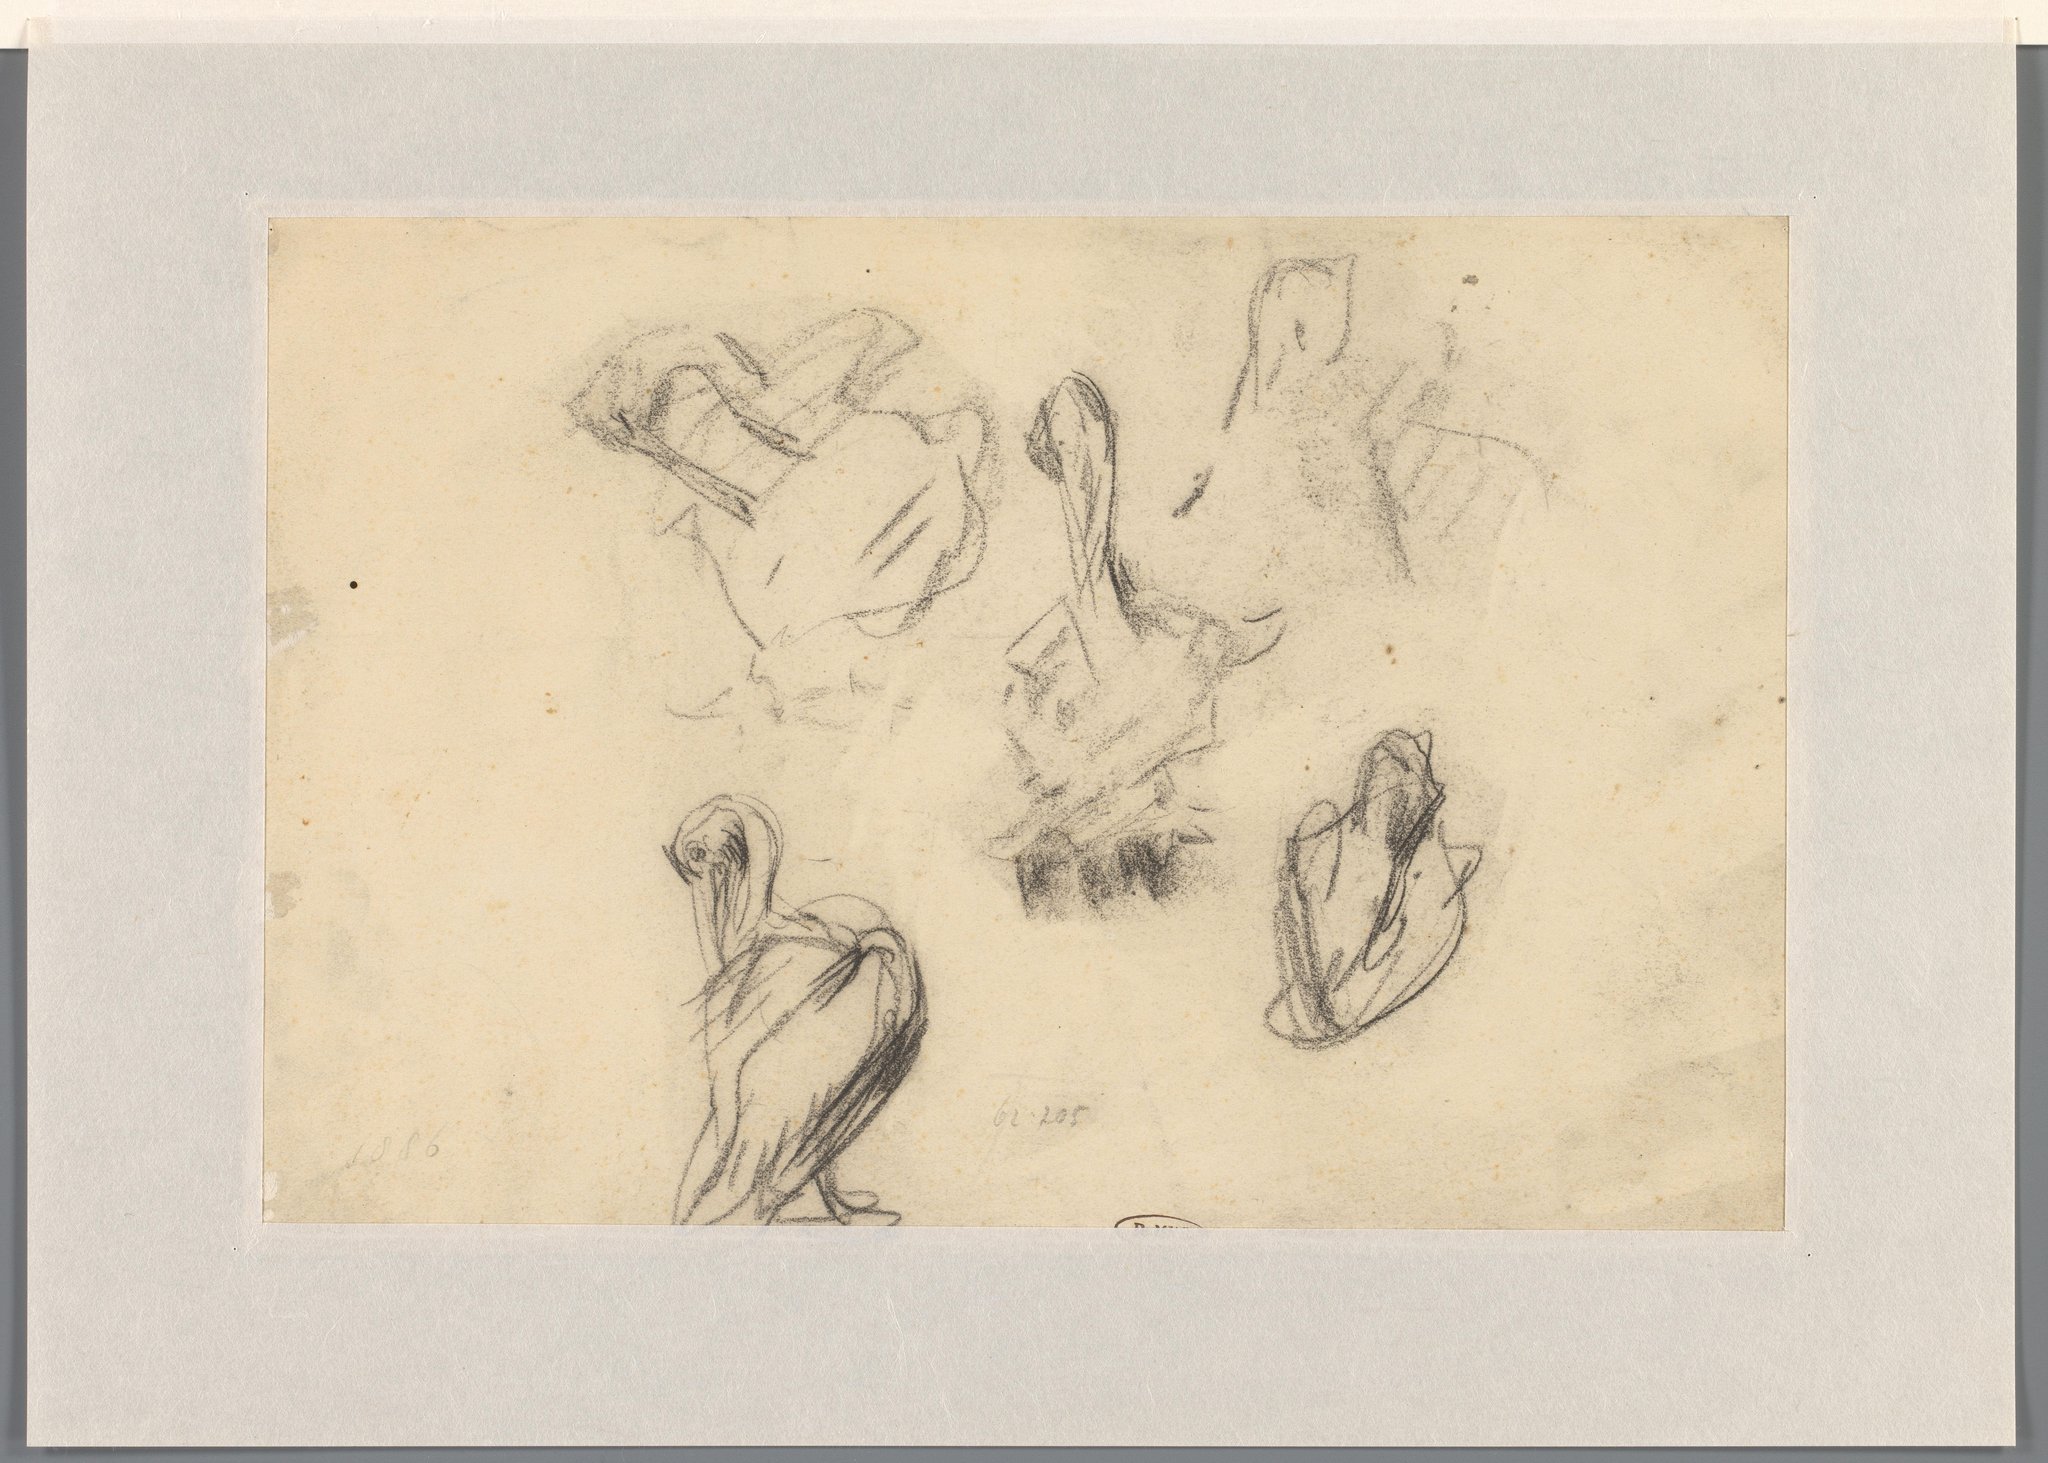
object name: drawing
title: Schetsen van een pelikaan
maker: jan veth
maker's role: designer, draughtsman, painter, print maker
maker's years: 1864-1925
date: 1886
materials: chalk, paper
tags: water-birds: pelican